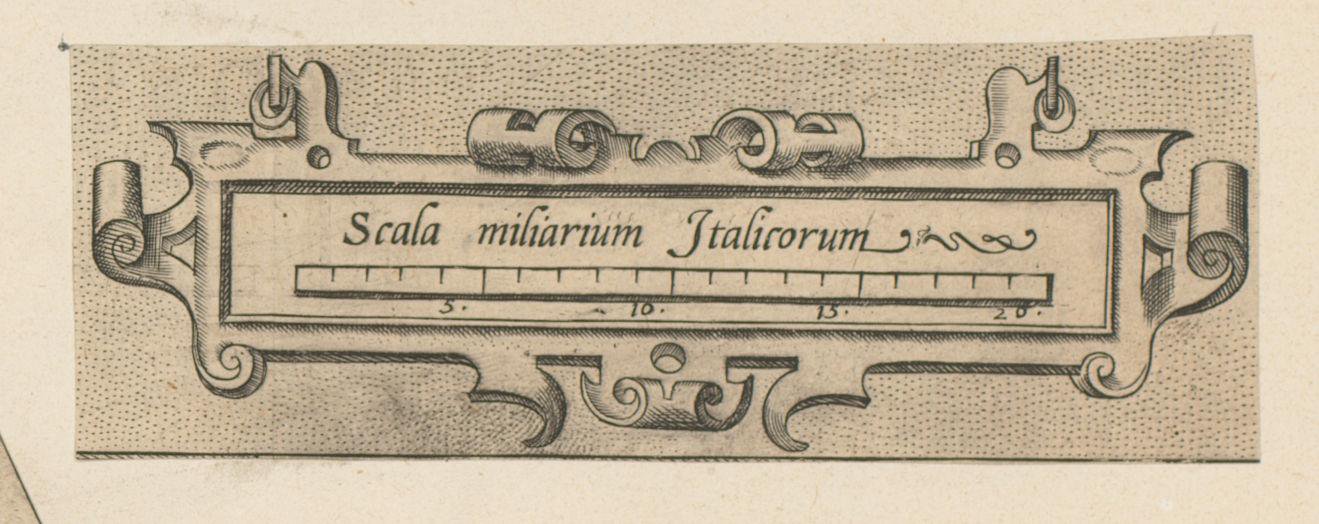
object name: album leaf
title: Langwerpige cartouche met schaalstok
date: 1570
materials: paper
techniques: engraving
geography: antwerp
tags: scrollwork, strapwork ~ ornament, ornament ~ cartouche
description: Langwerpige cartouche met schaalstok. De cartouche is een fragment van een kaart van Piëmont. De prent maakt deel uit van een album.